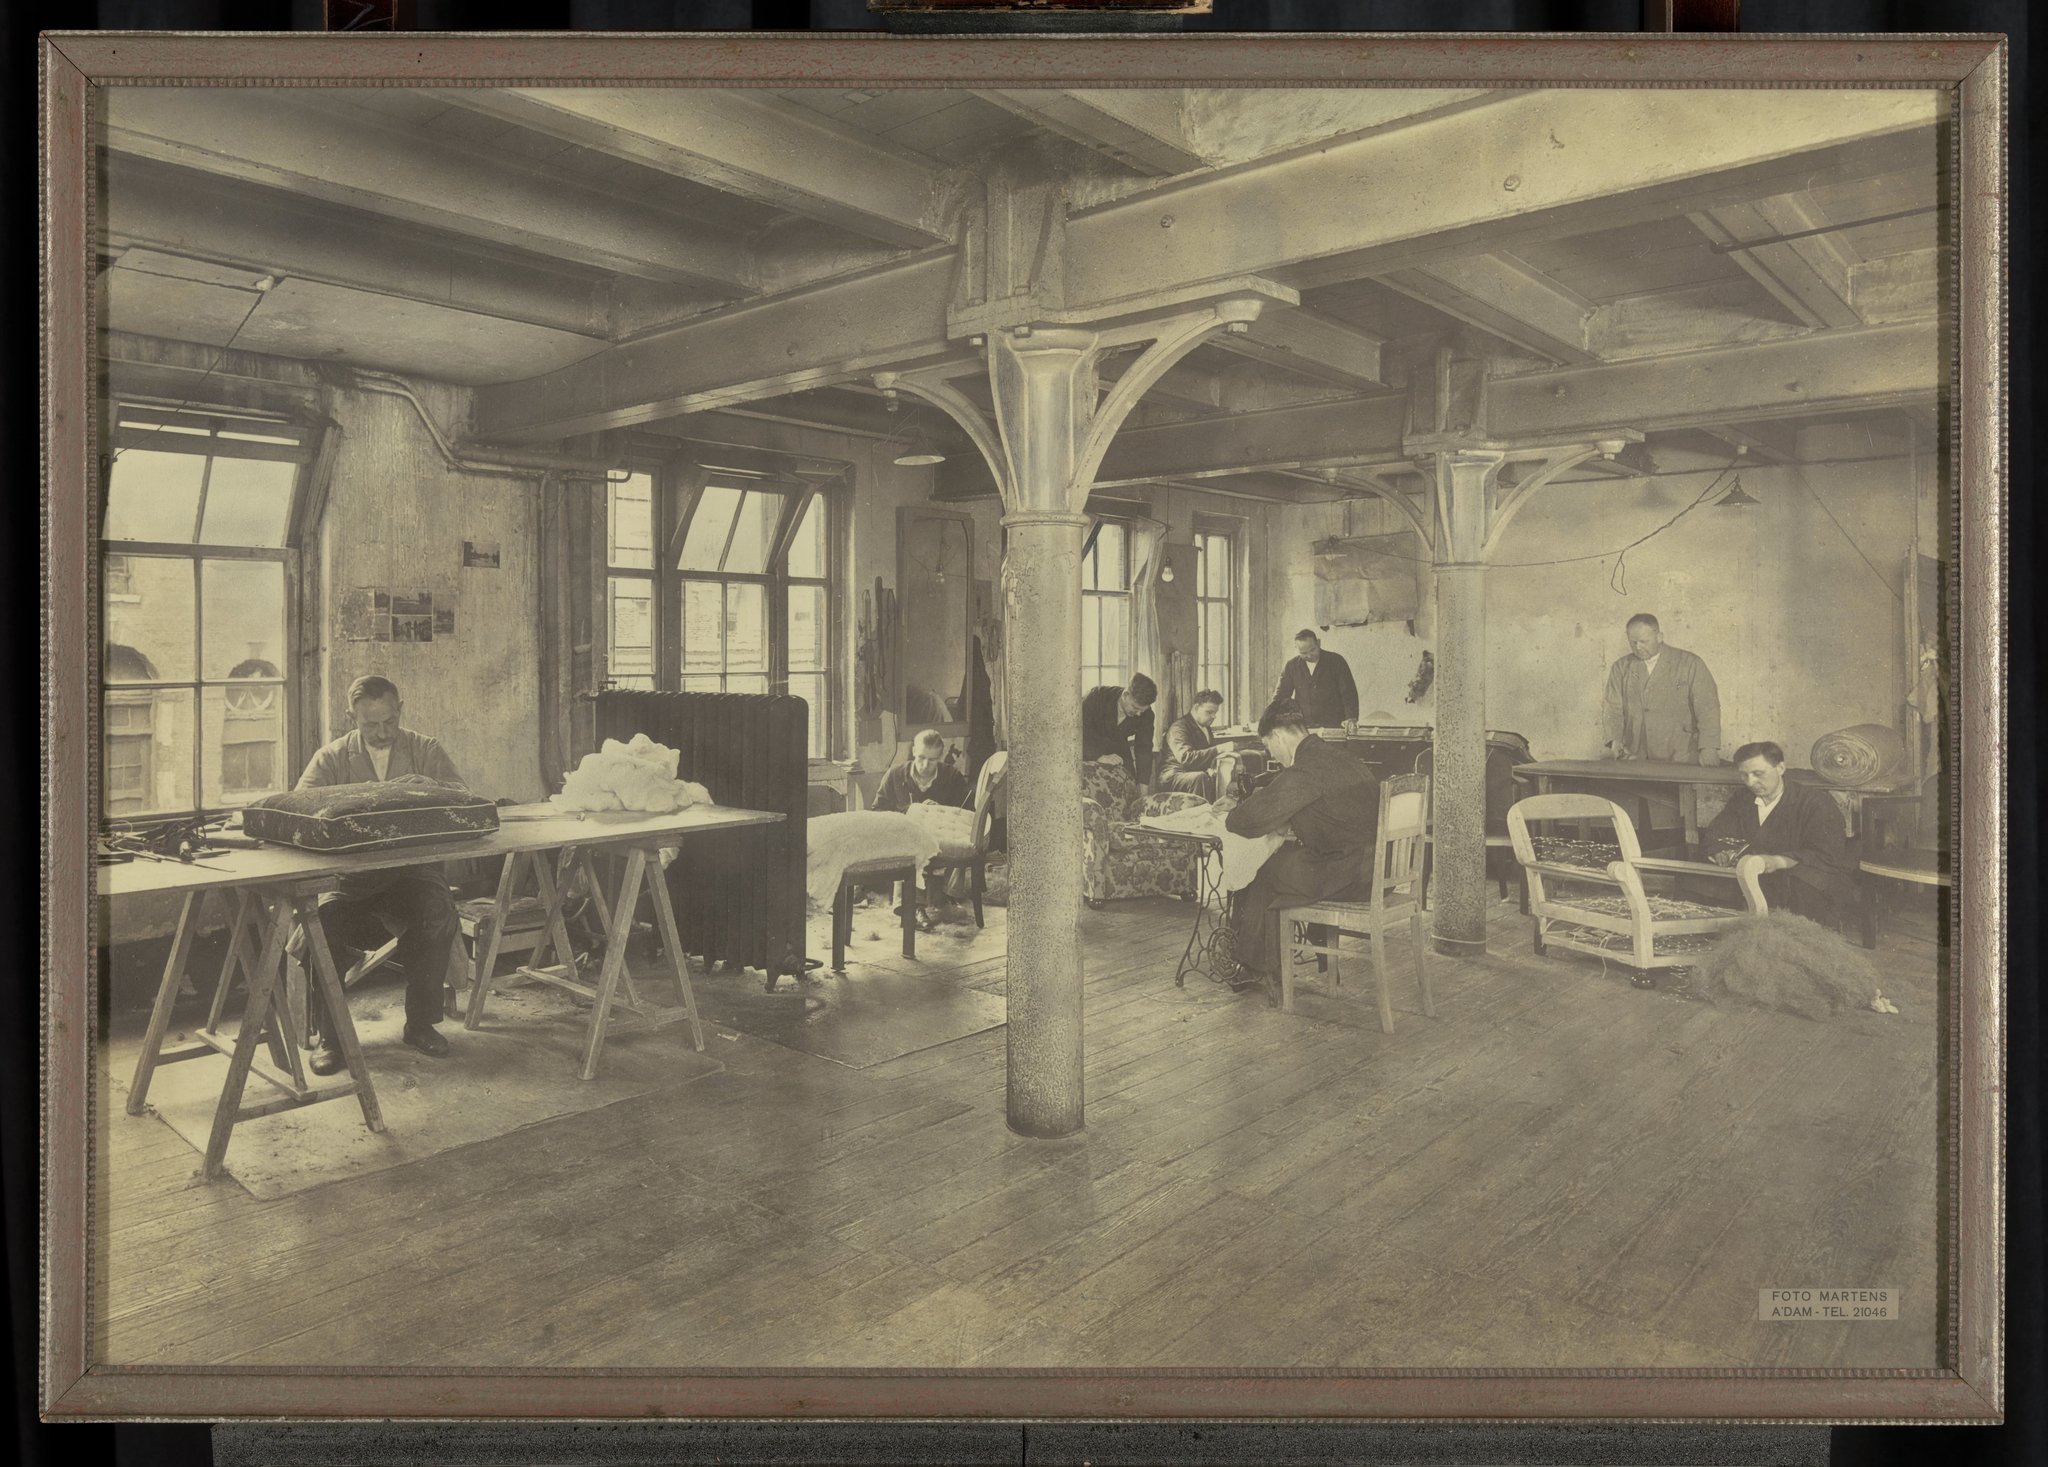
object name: photograph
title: werkplaats van 't Woonhuys, Amsterdam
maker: martens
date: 1925-1940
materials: cardboard, glass, photographic support, wood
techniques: gelatin silver print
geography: amsterdam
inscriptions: label: ‘FOTO MARTENS / A'DAM - TEL. 21046’